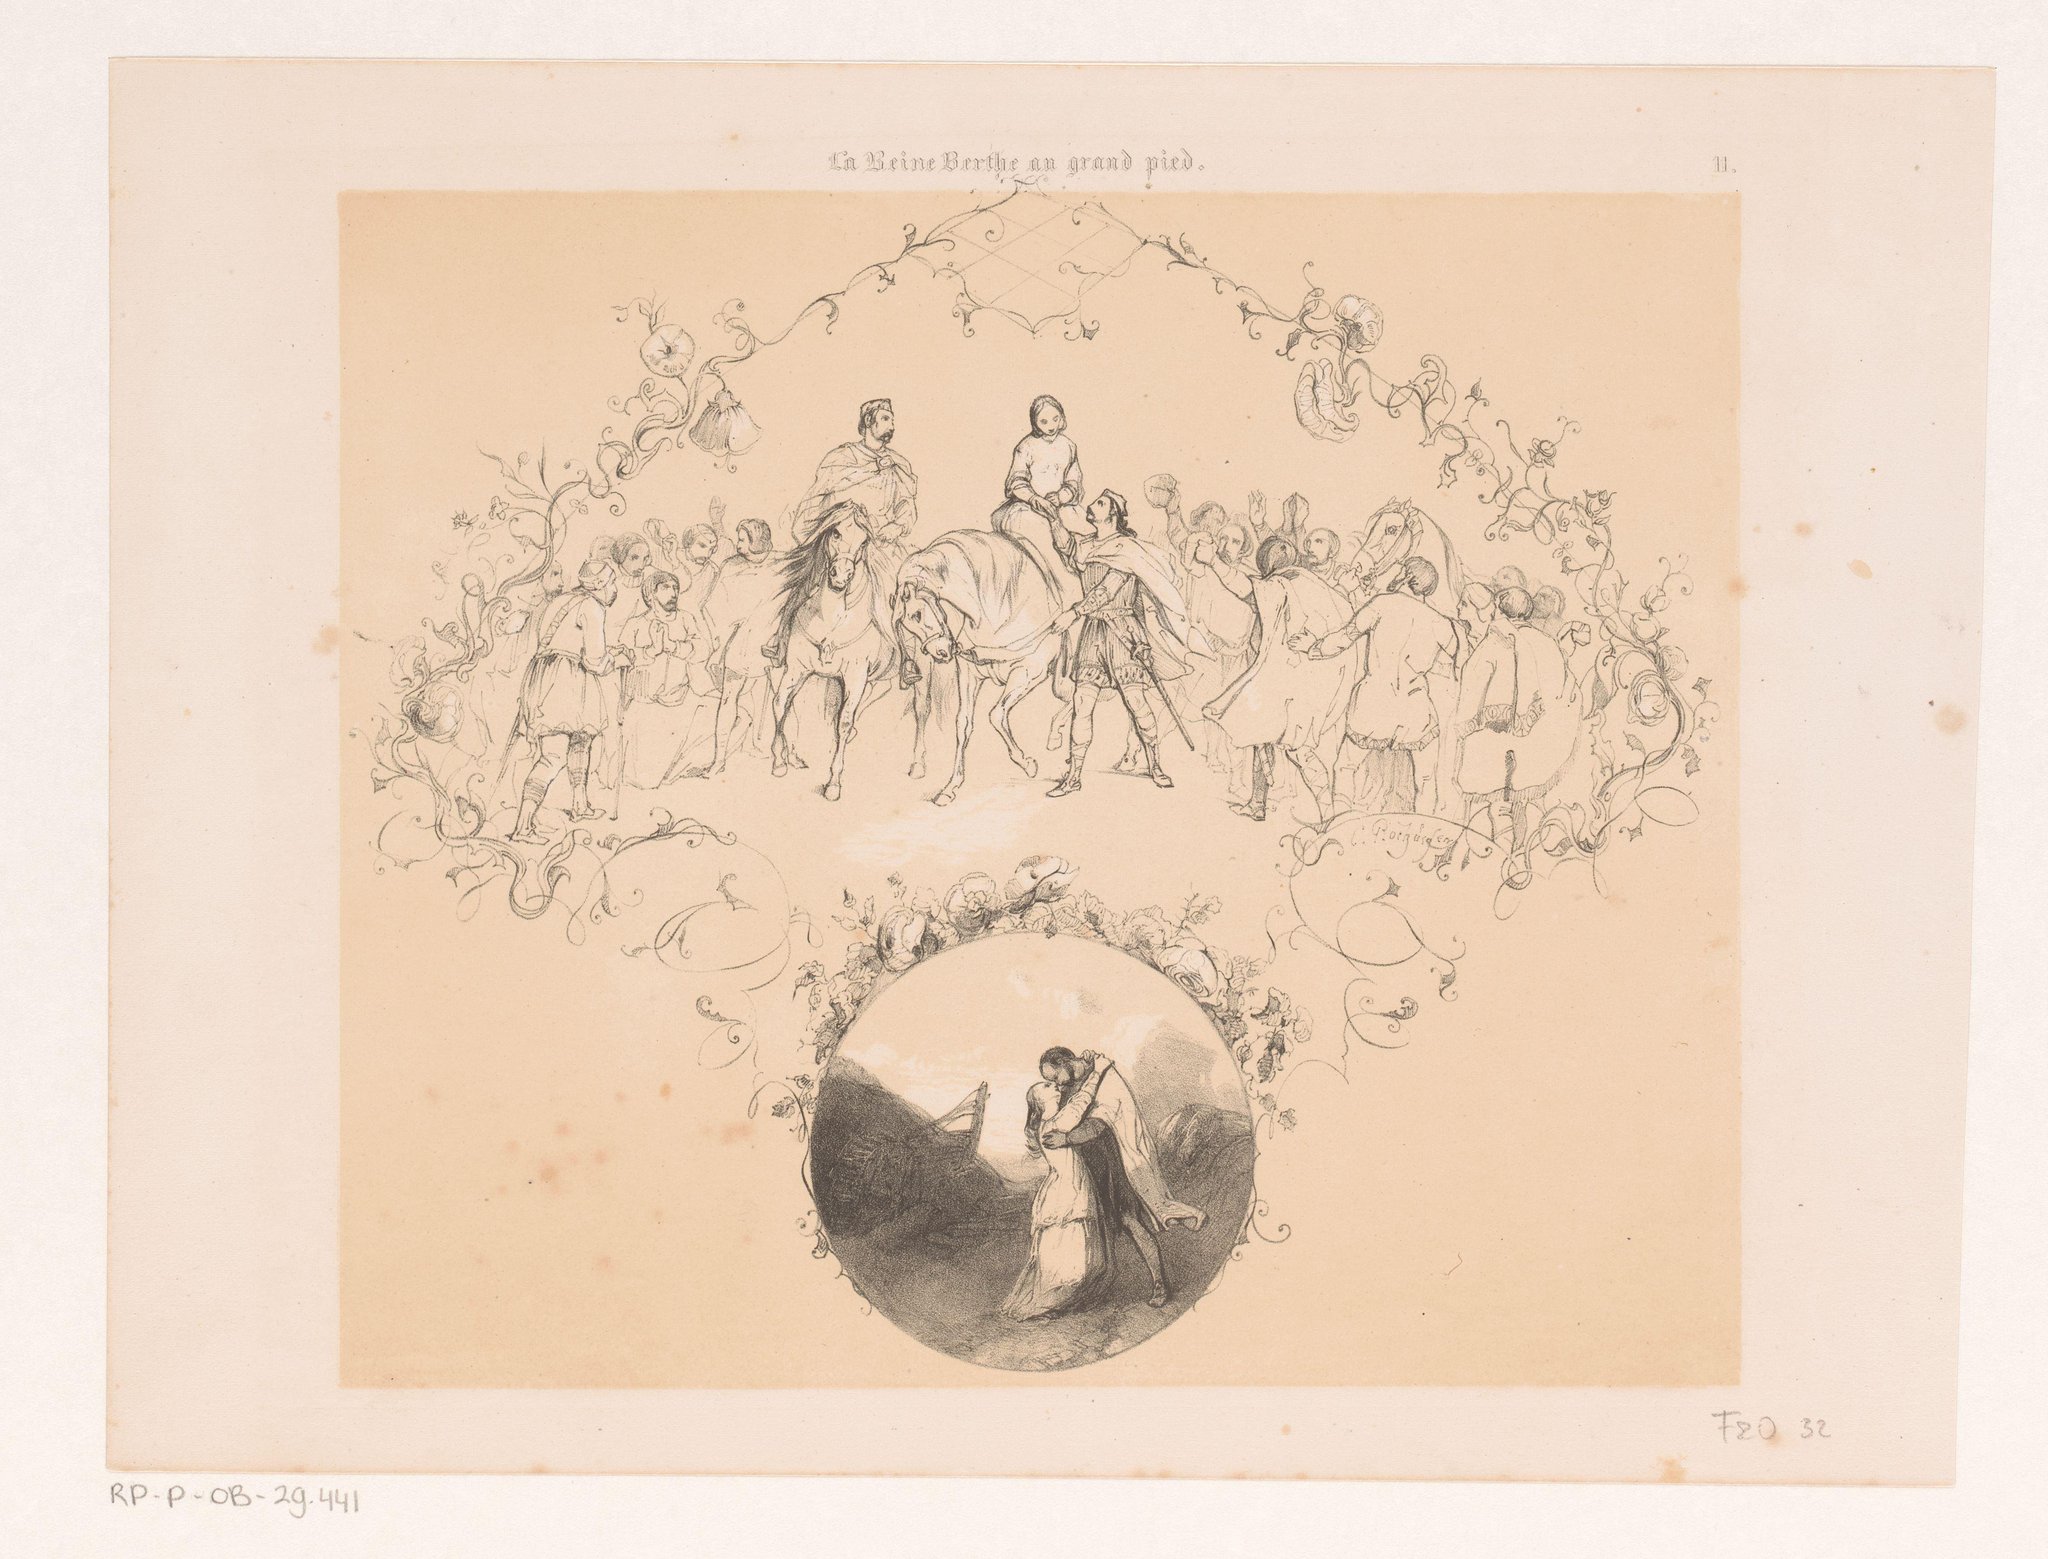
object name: book illustration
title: Verliefd koppel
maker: charles rochussen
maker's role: draughtsman, painter, print maker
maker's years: 1814-1894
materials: paper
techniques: tone lithography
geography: the hague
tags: couple of lovers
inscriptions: collector's mark: Lugt 2228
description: Prent uit: Plancy, Jacques Collin de. La Reine Berthe au grand pied. Den Haag: Nederlandsche Maatschappij van Schoone Kunsten, 1842.